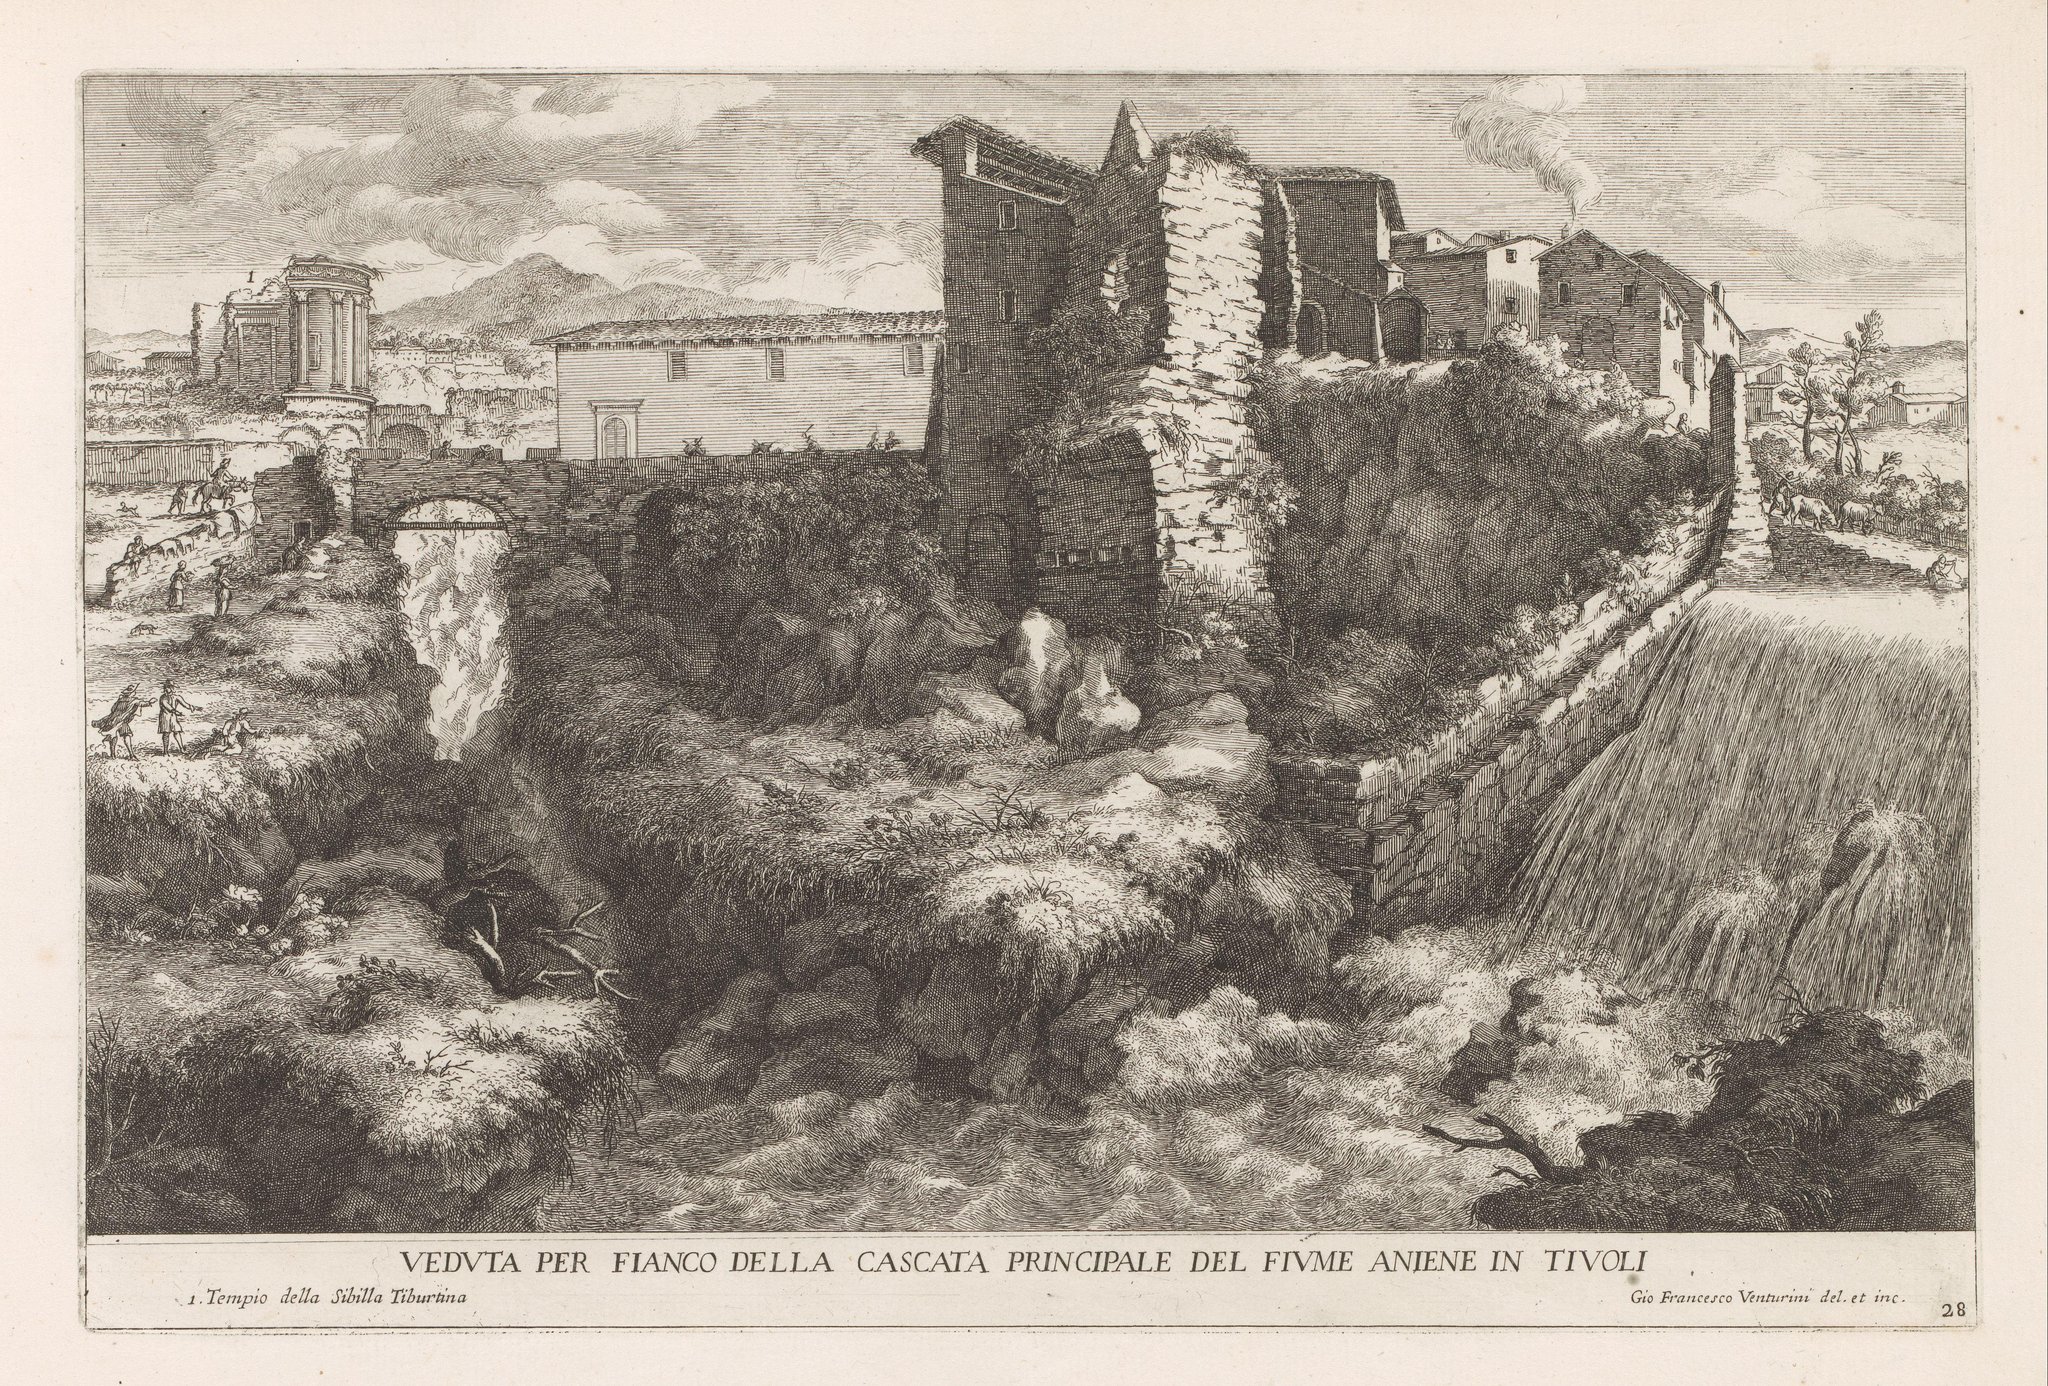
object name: album leaf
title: Veduta per fianco della cascata principale del fiume Aniene in Tivoli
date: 1653-1691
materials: paper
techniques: etching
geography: italy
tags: city-view, and landscape with man-made constructions, waterfall, temple, shrine ~ roman religion, tivoli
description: Landschap met rechts een waterval in de rivier de Aniene en links de restanten van de ronde tempel van de Tiburtijnse Sibille. Genummerd rechtsonder: 28. De prent maakt deel uit van een album.